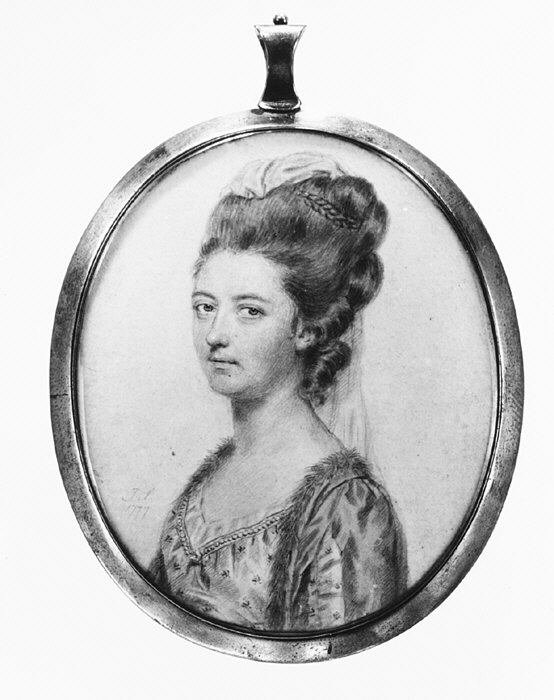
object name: painting, miniature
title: Mrs. Charlotte Lennox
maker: john smart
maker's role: artist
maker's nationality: british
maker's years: 1741-1811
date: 1777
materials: pencil, watercolor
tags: portraits,women